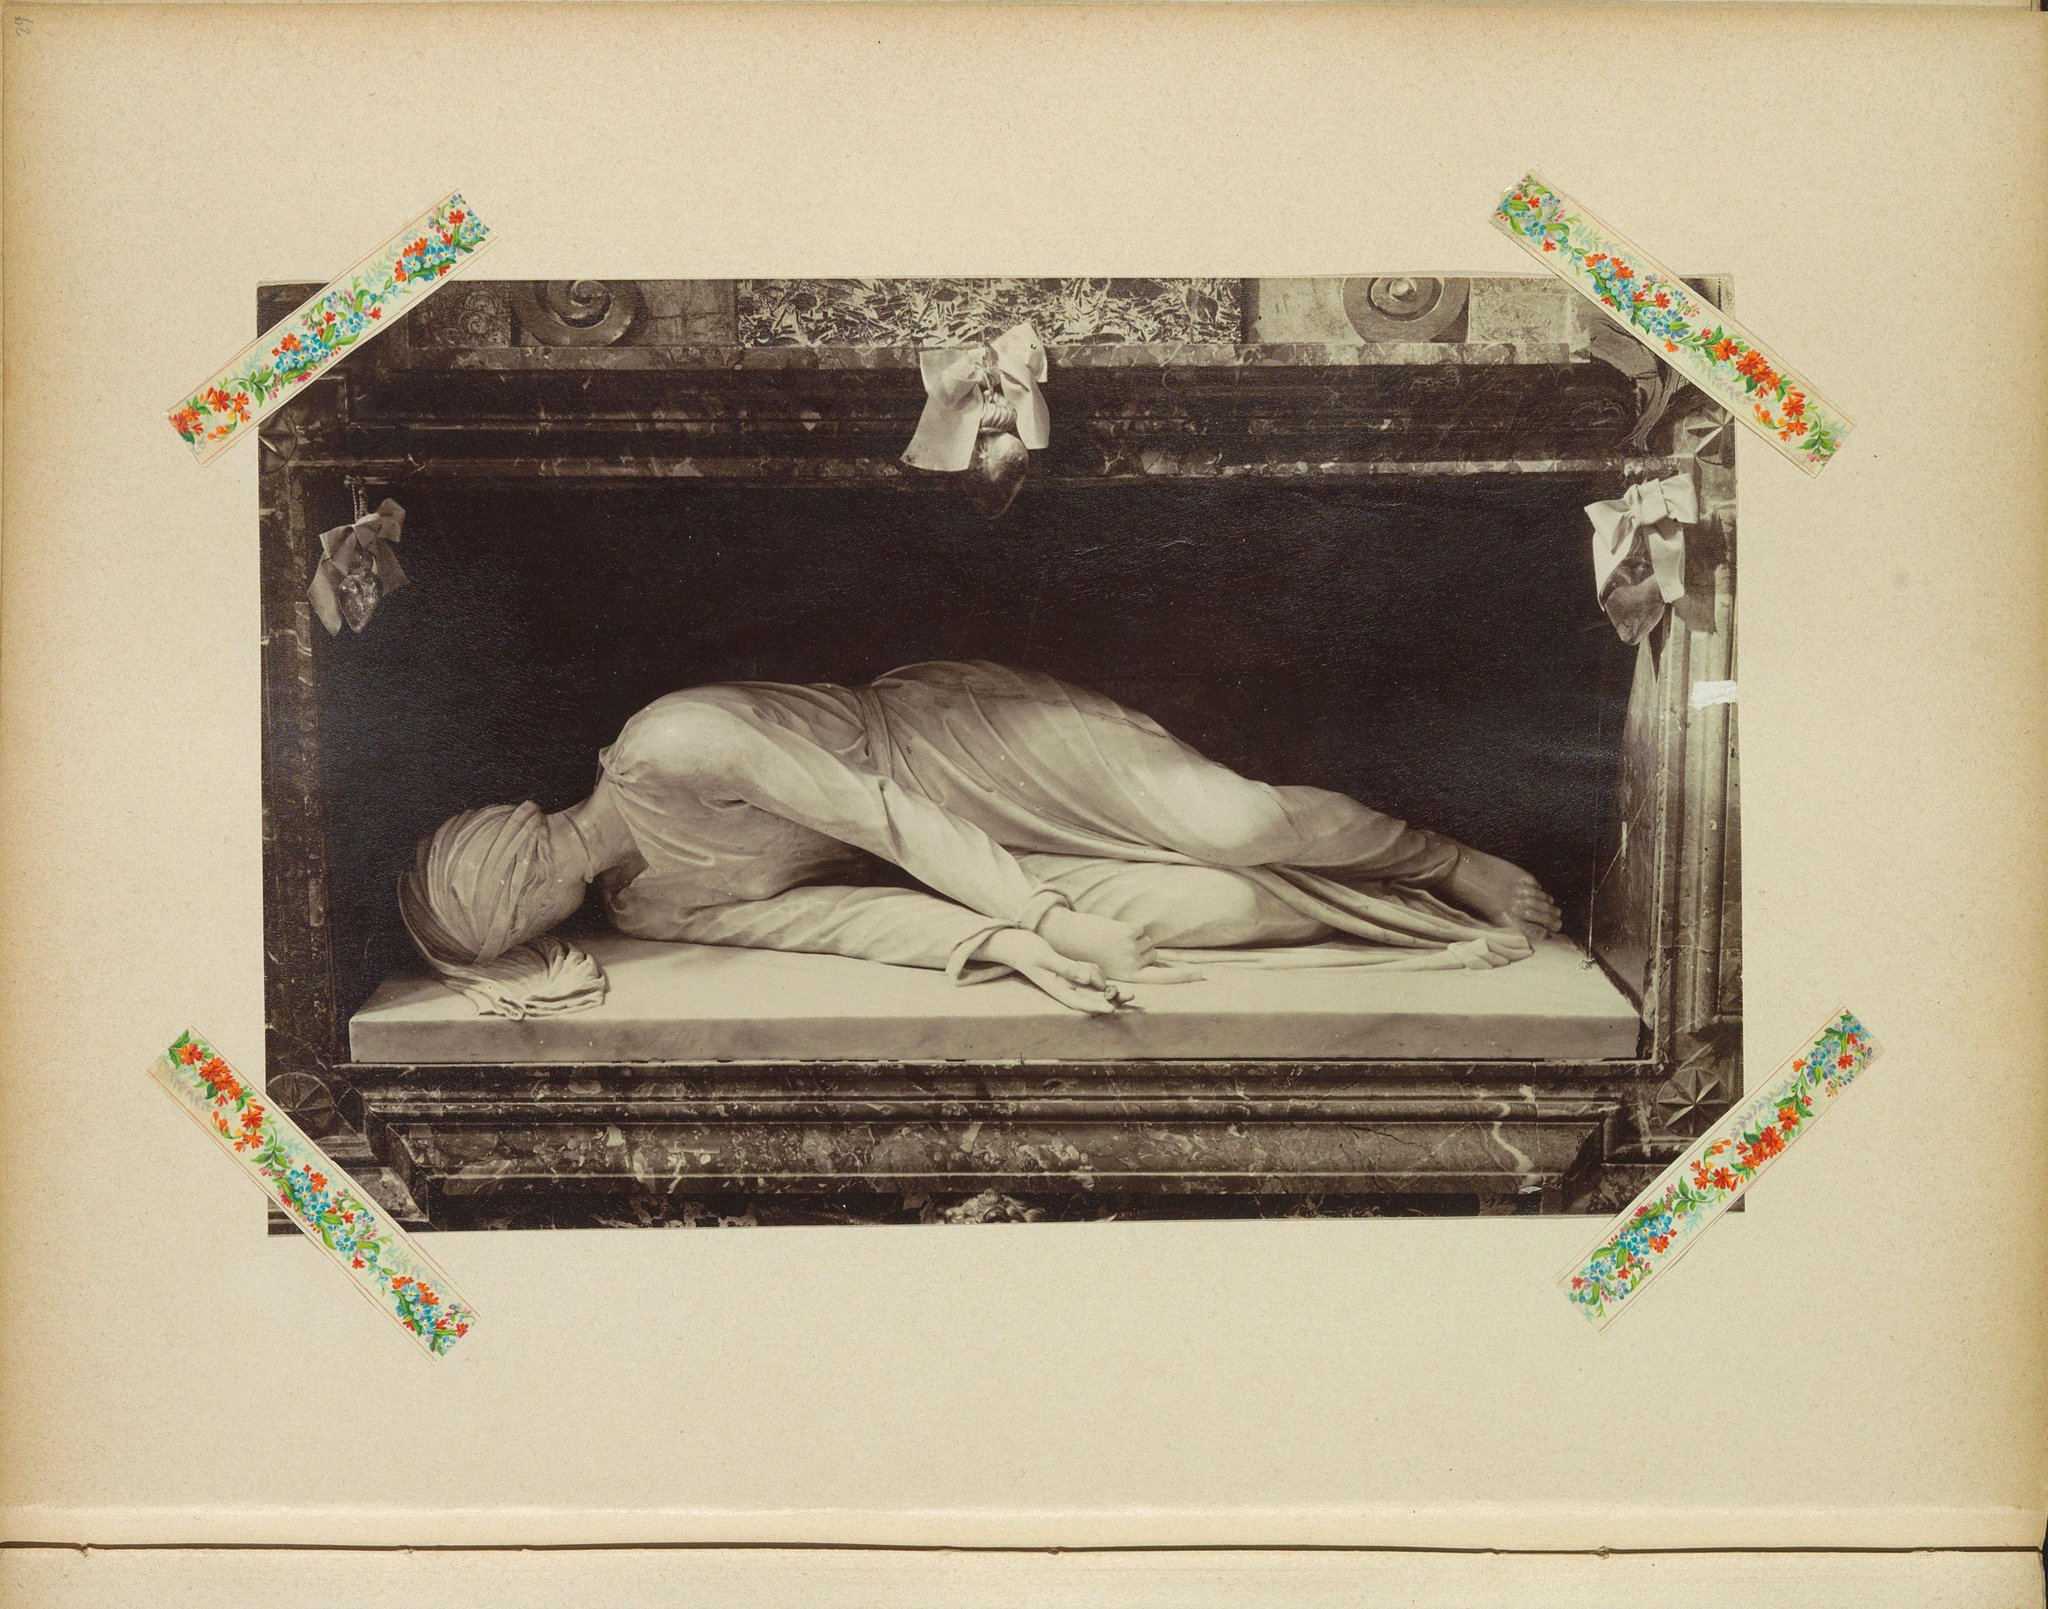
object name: photograph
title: Beeld van de heilige Cecilia in de basiliek van Santa Cecilia in Rome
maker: Anonymous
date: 1860-1900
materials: photographic support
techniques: albumen print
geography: rome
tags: death of cecilia: she lies down with three wounds in her neck, rome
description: Onderdeel van Fotoalbum met opnames van bezienswaardigheden in Italiaanse steden en van kunstwerken.